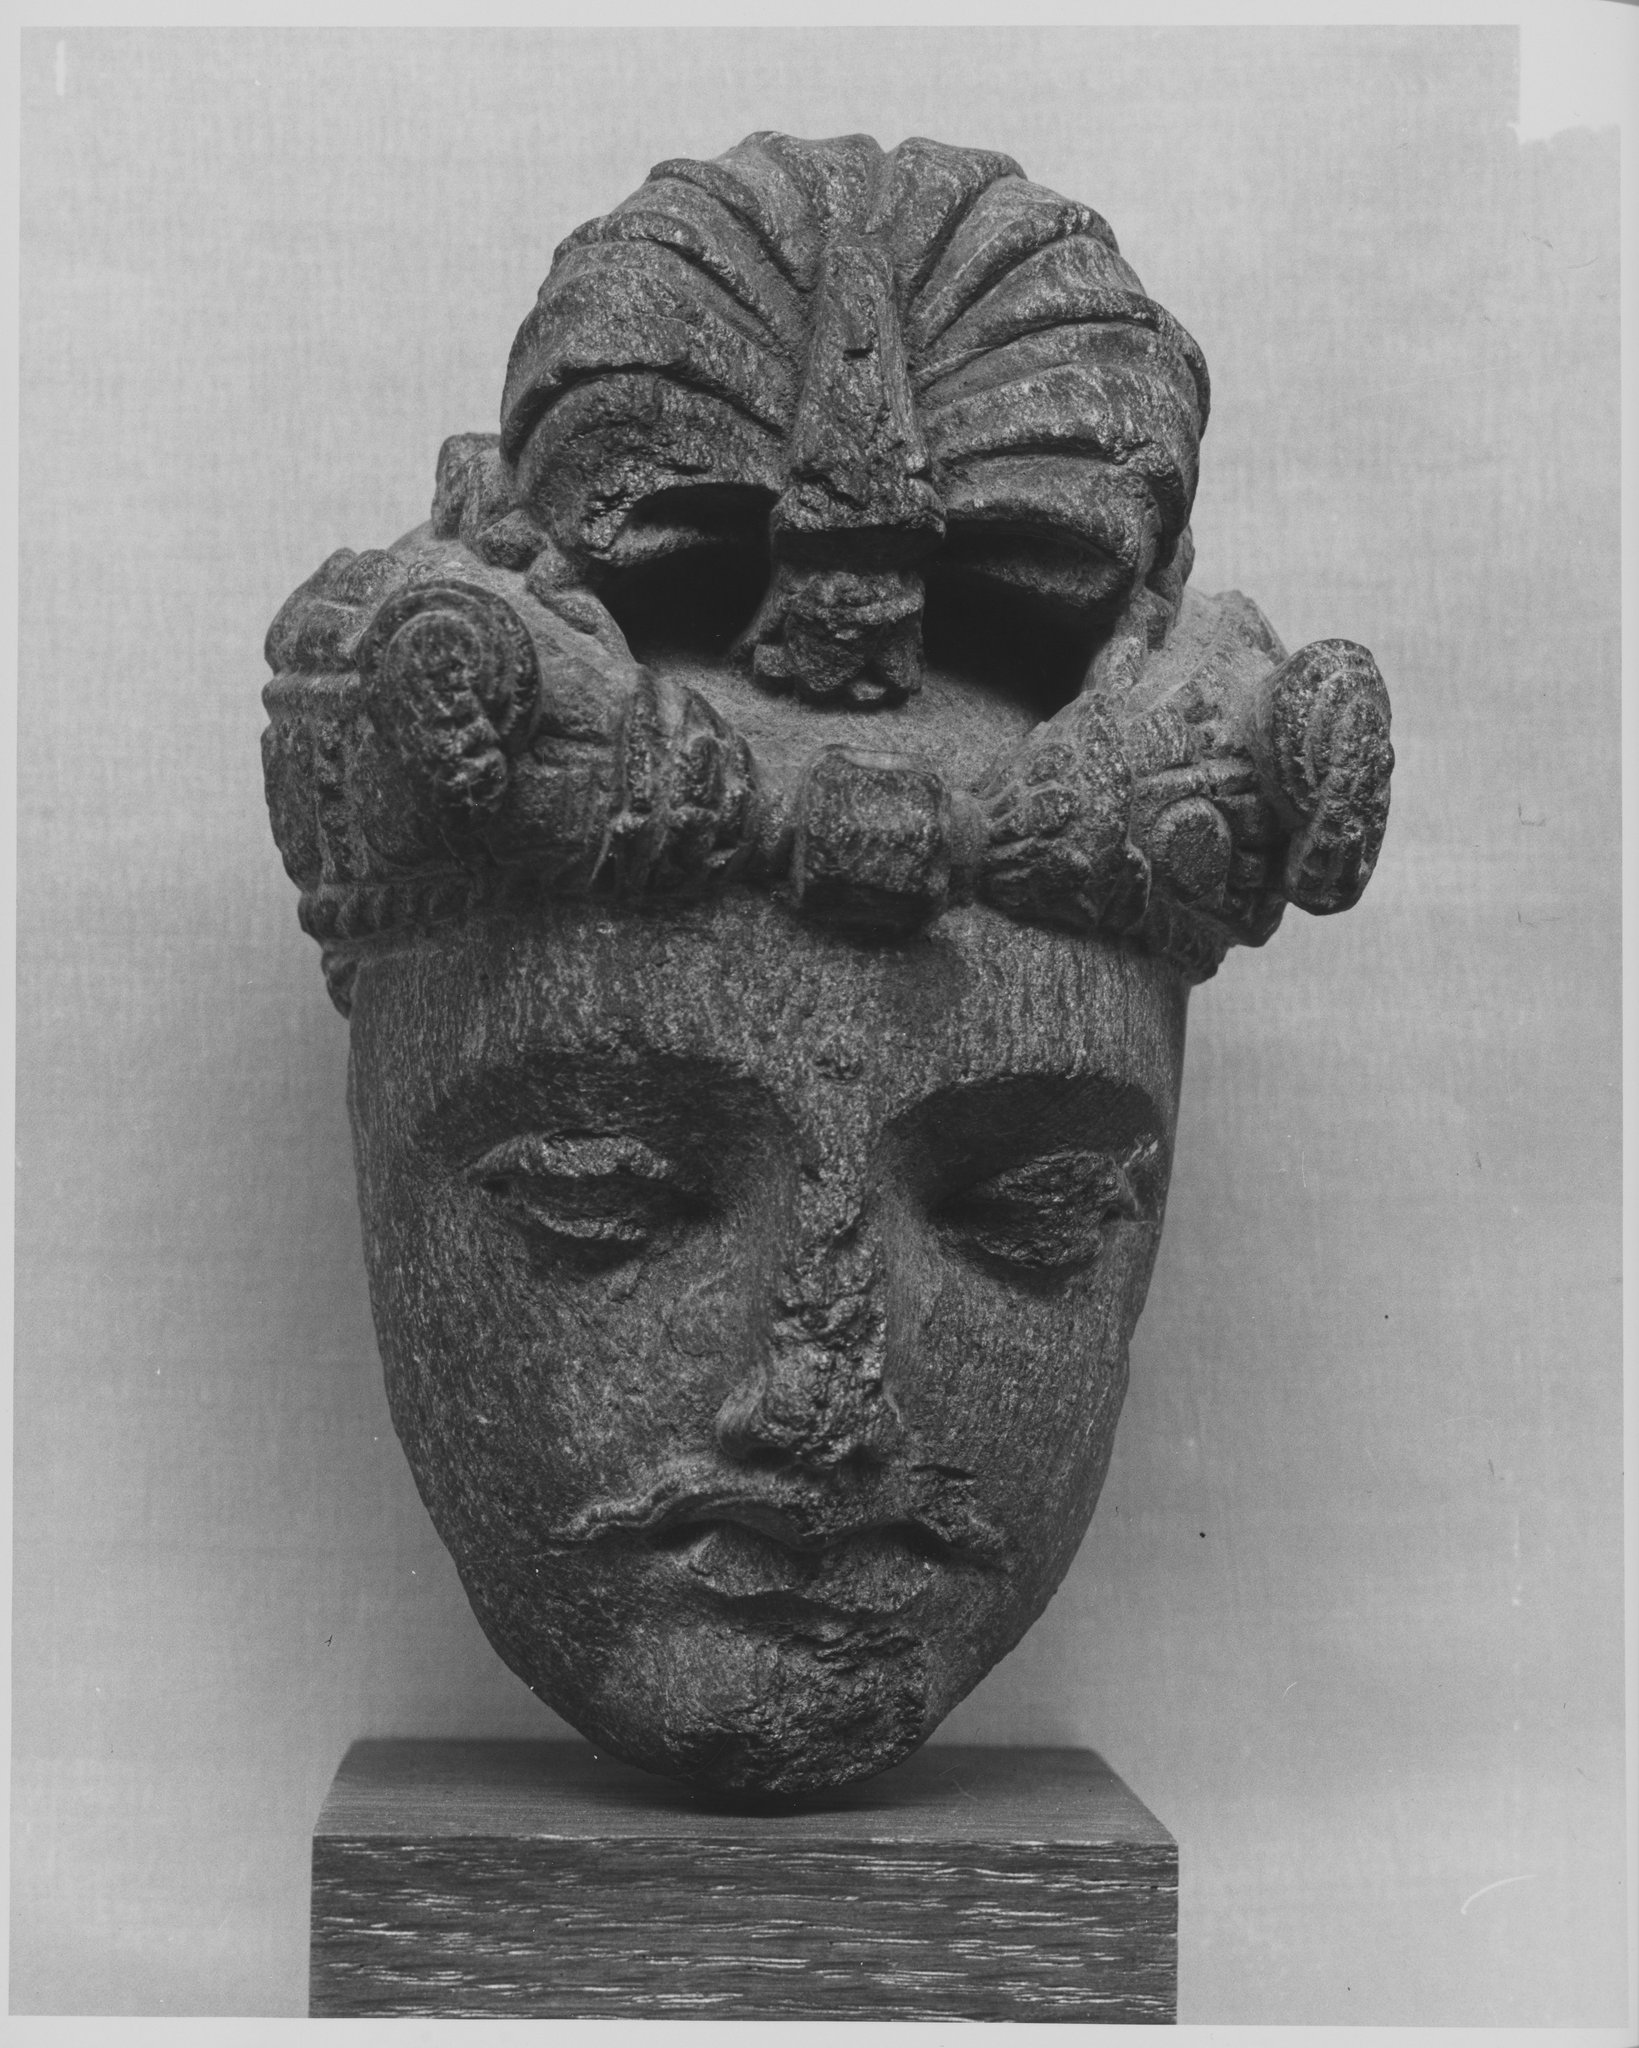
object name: head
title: Head of a Bodhisattva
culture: gandhara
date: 201-500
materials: stone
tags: gandhara,heads,buddhism,bodhisattvas